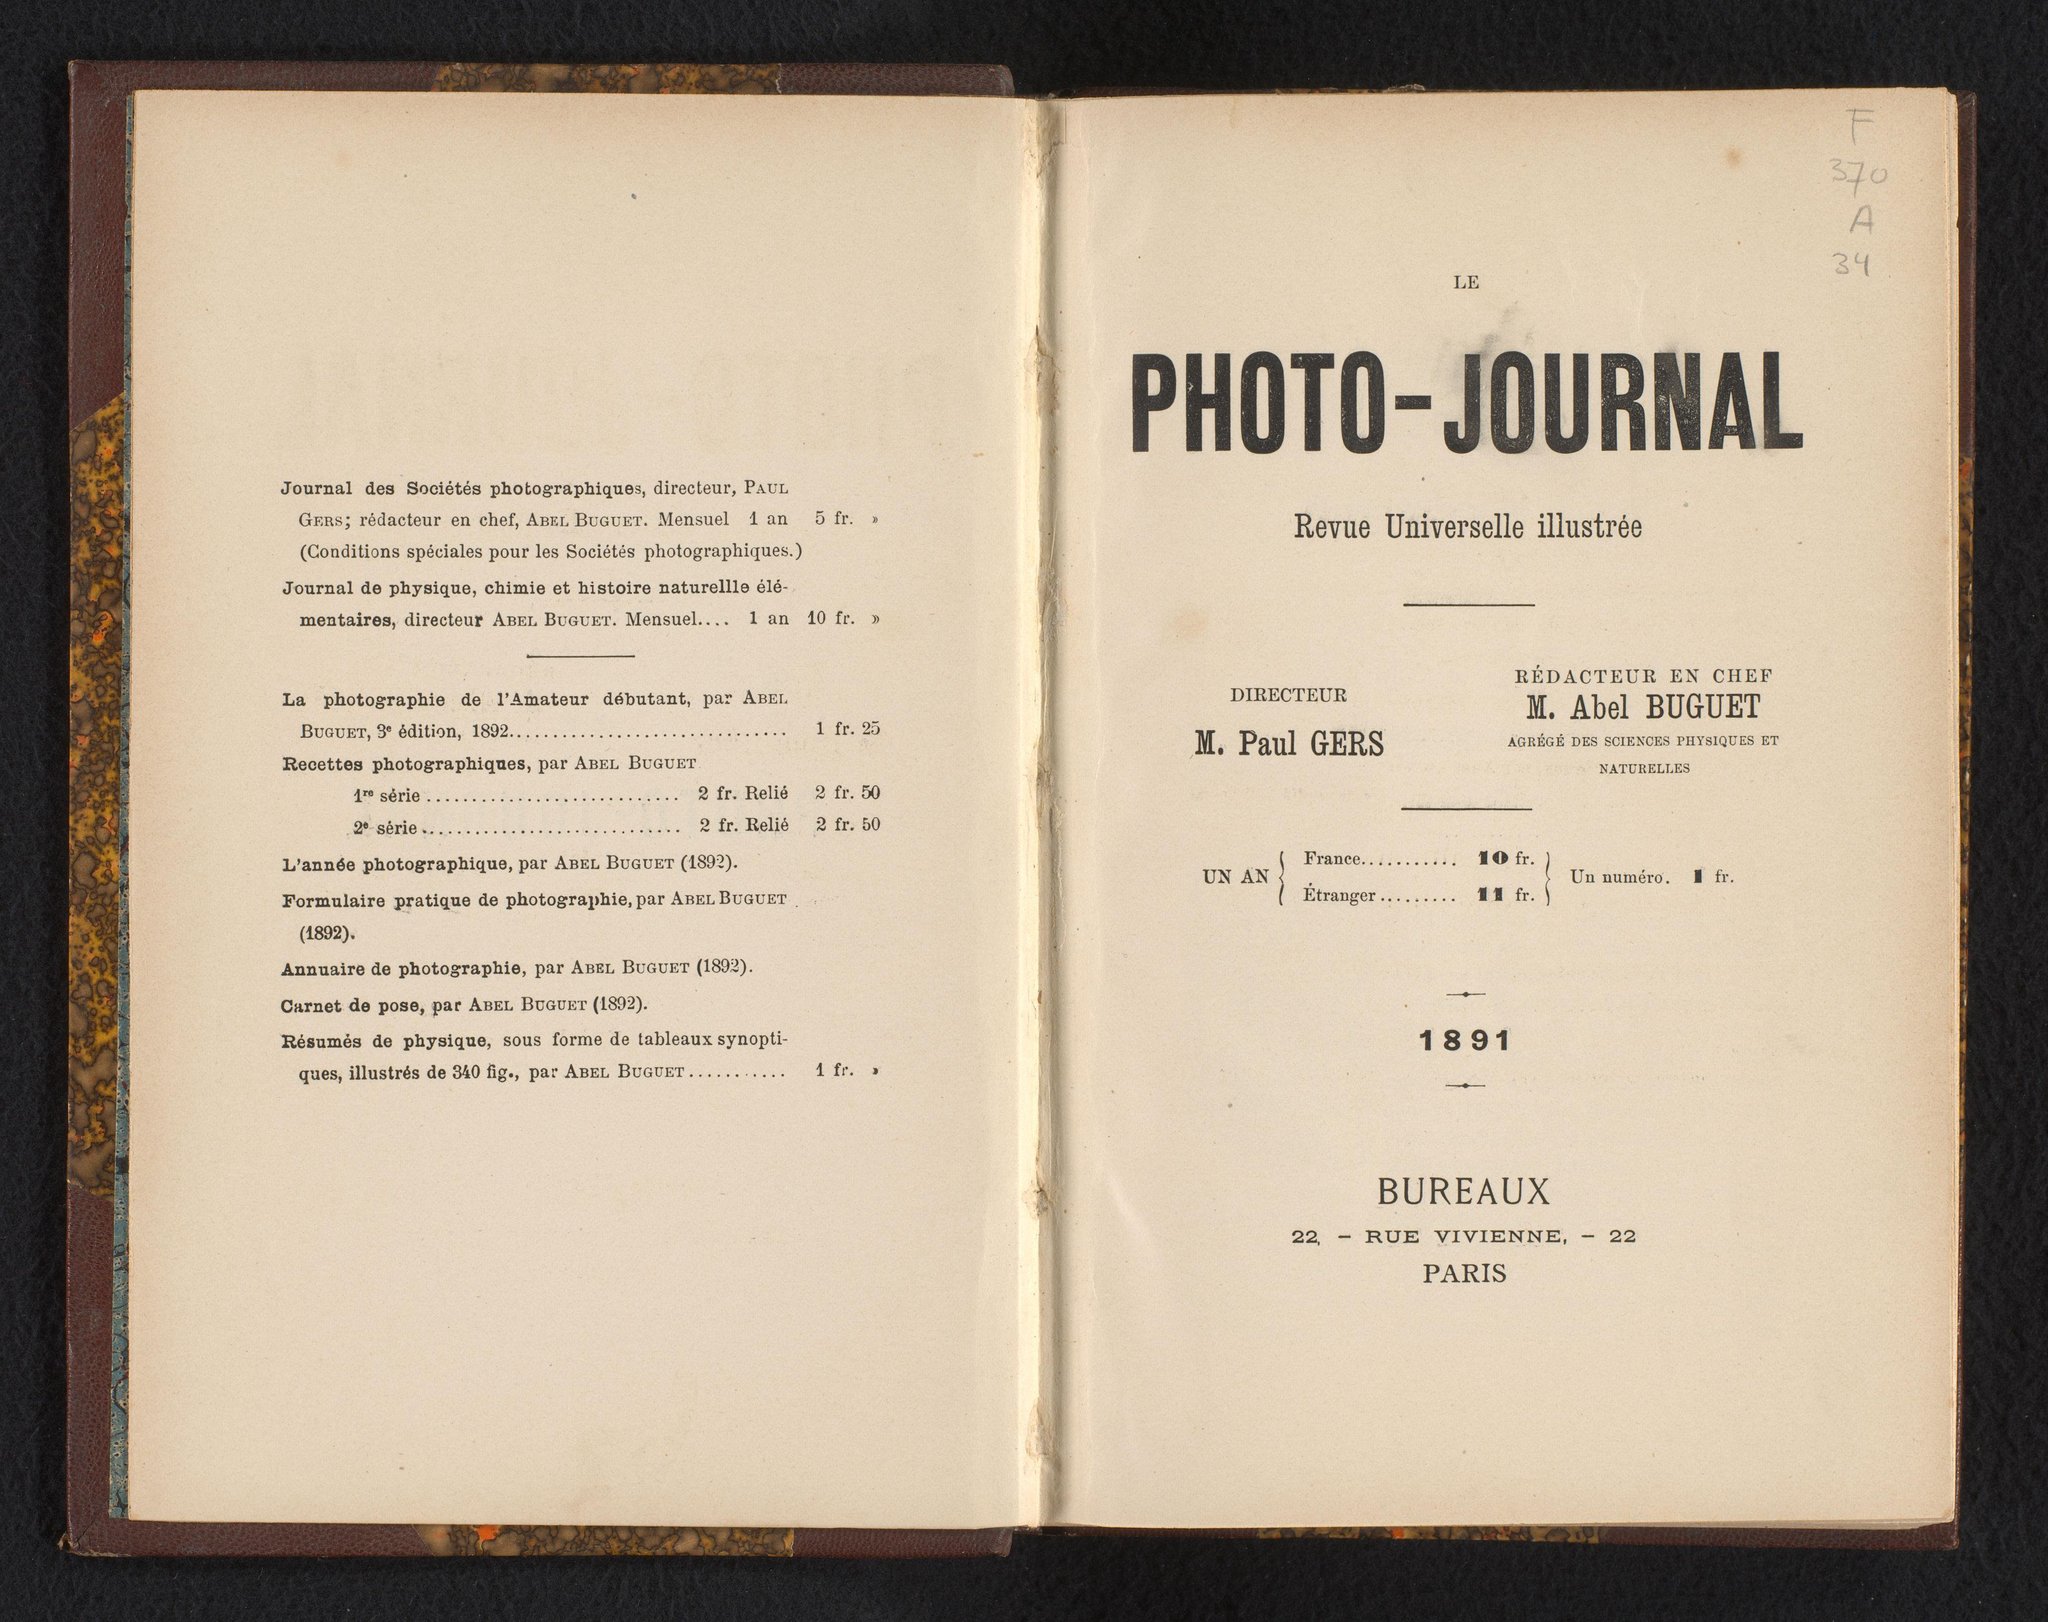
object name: book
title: Le Photo-Journal. Revue universelle illustrée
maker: Anonymous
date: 1891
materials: cardboard, leather, paper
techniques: photograph, marbling, printing, marbled paper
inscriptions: inscription: ‘Société Niortaise de photographie Rue de la Bibliothèque’